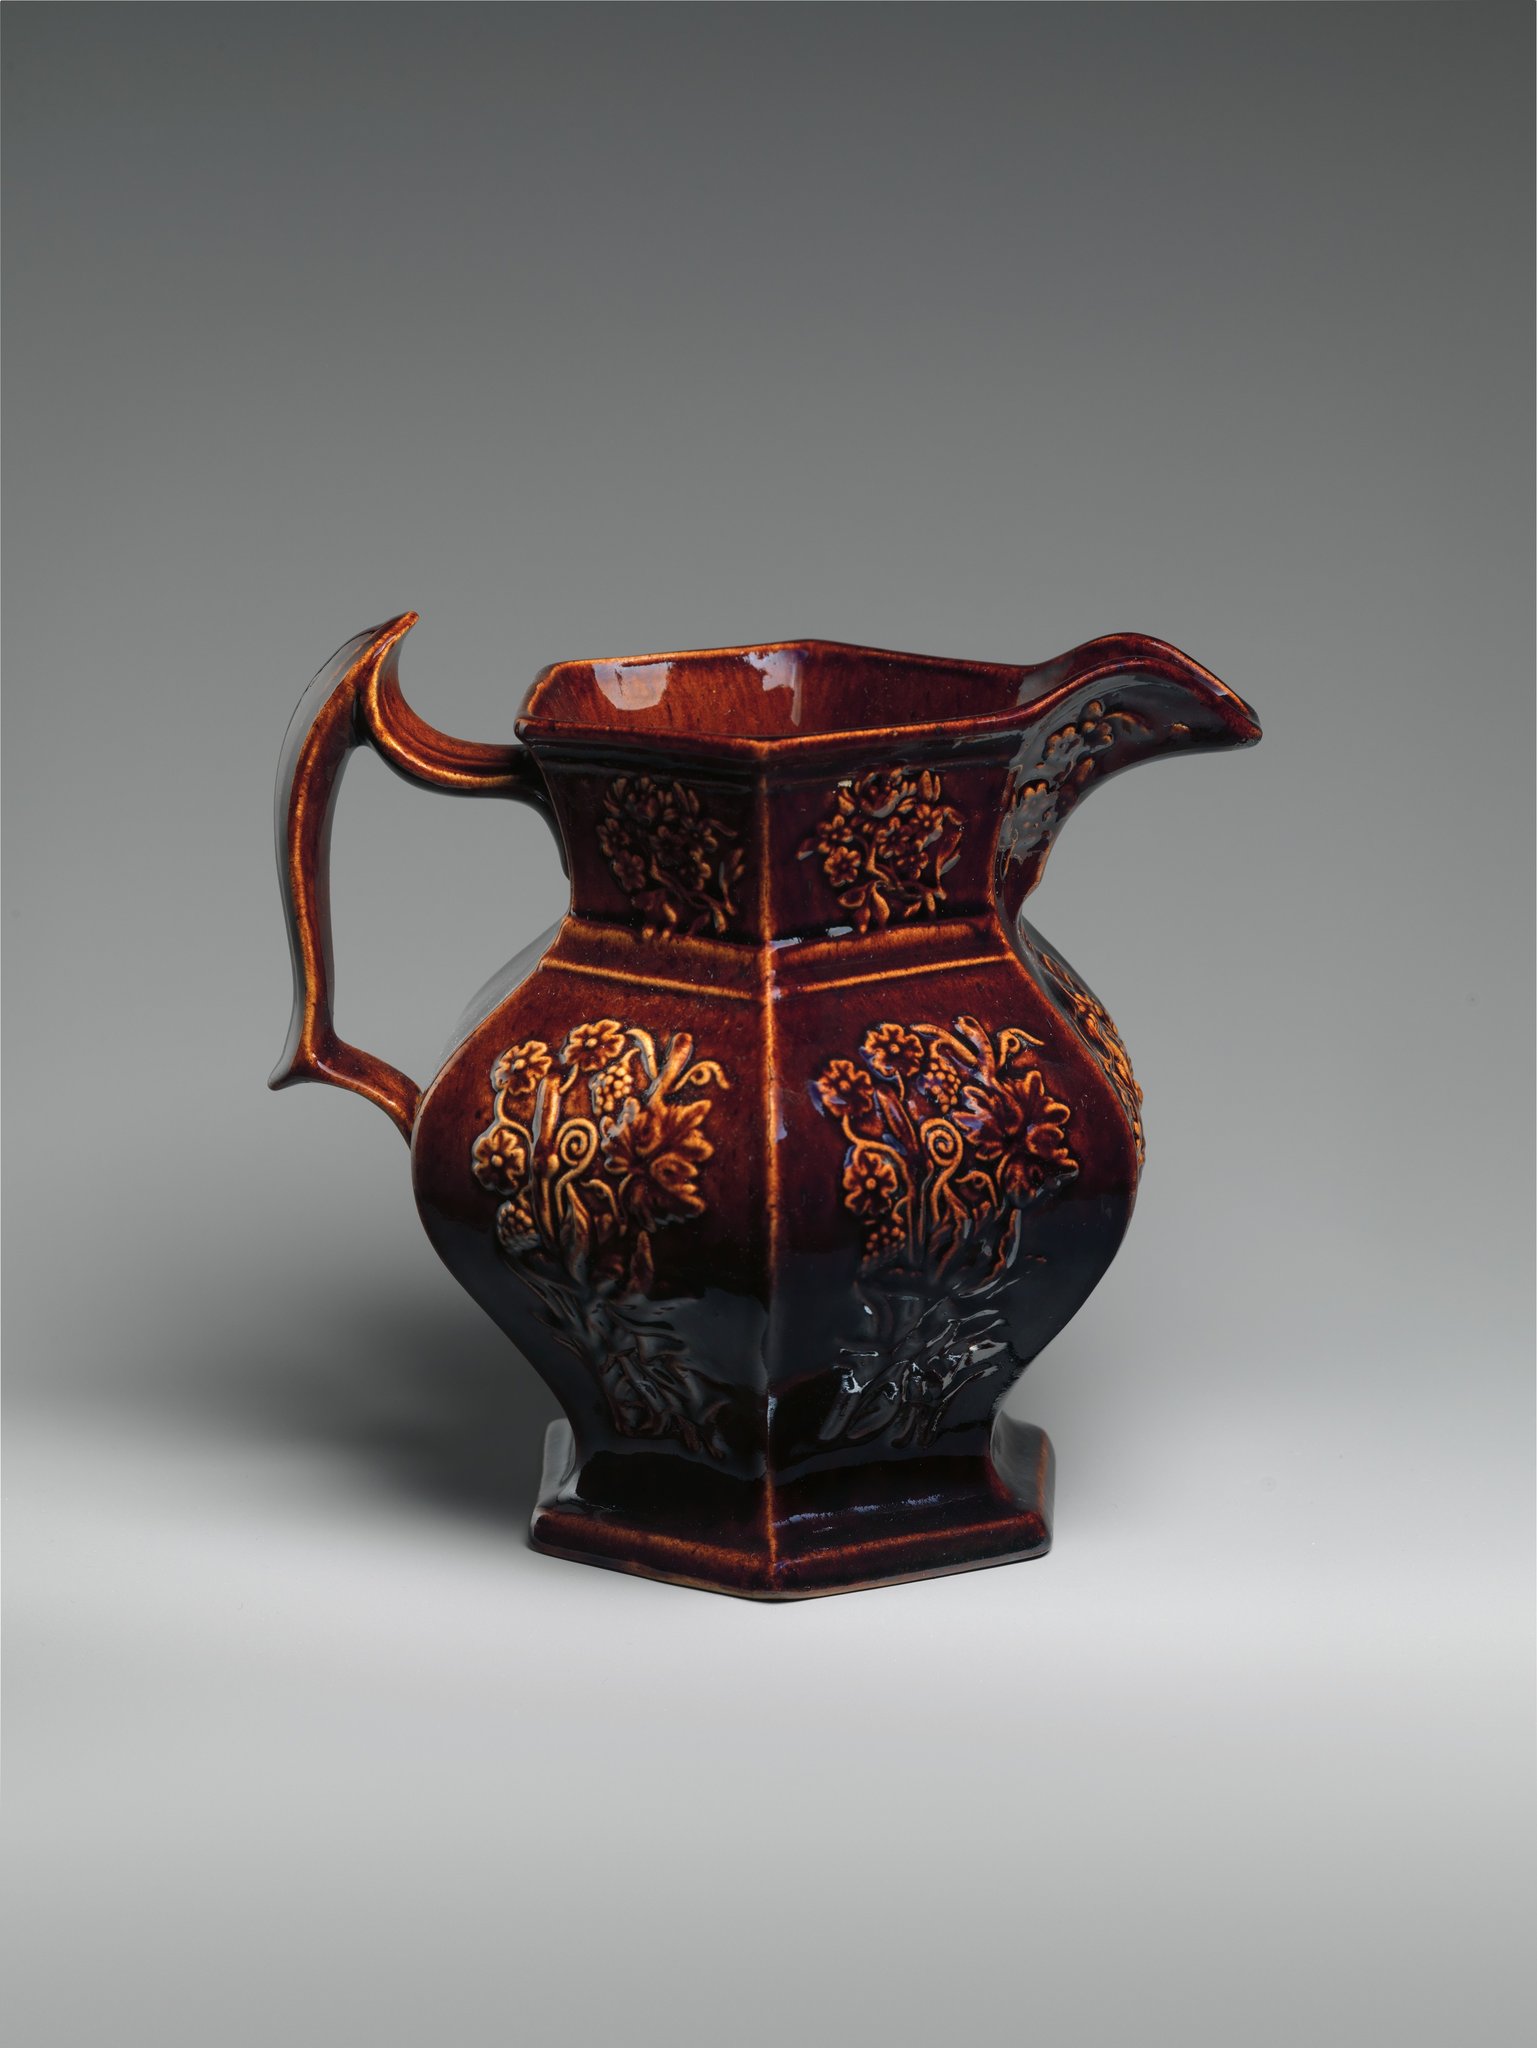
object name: pitcher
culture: american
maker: norton and fenton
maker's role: maker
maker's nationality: american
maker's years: 1845-1847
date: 1845-1847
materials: earthenware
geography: united states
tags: flowers